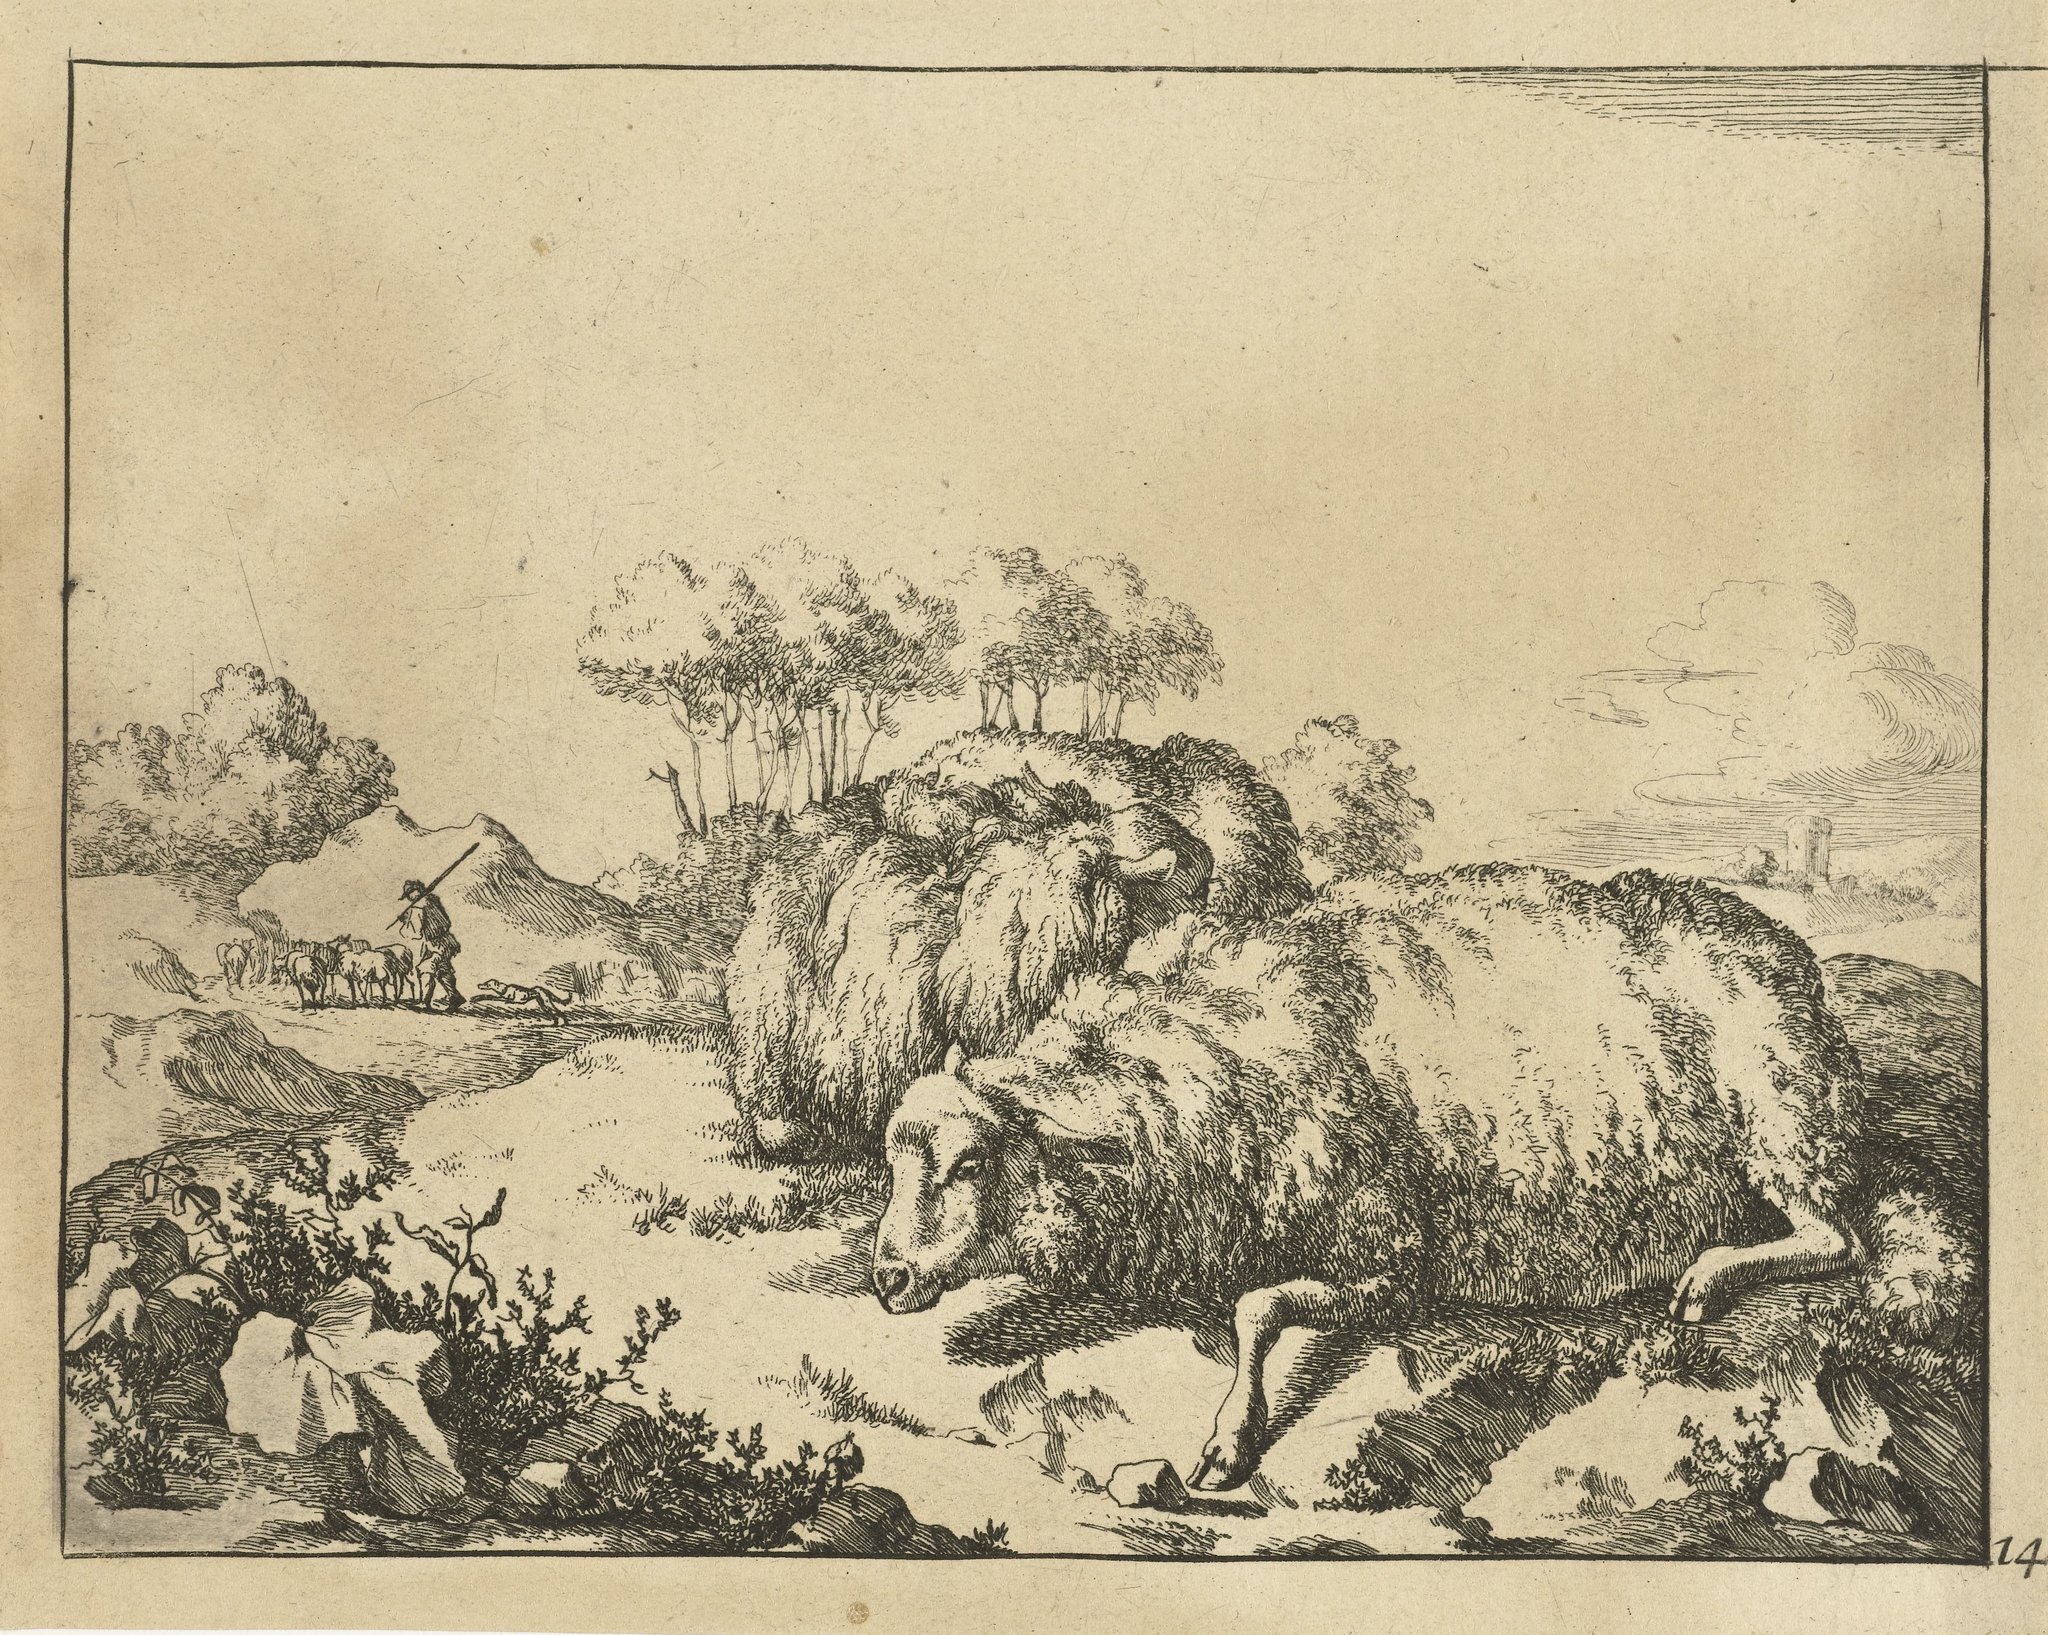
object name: print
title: Twee schapen, liggend, met herder op achtergrond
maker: marcus de bye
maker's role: print maker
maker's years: 1639-1688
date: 1660-1664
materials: paper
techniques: etching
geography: the hague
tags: sheep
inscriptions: collector's mark: Lugt 2228